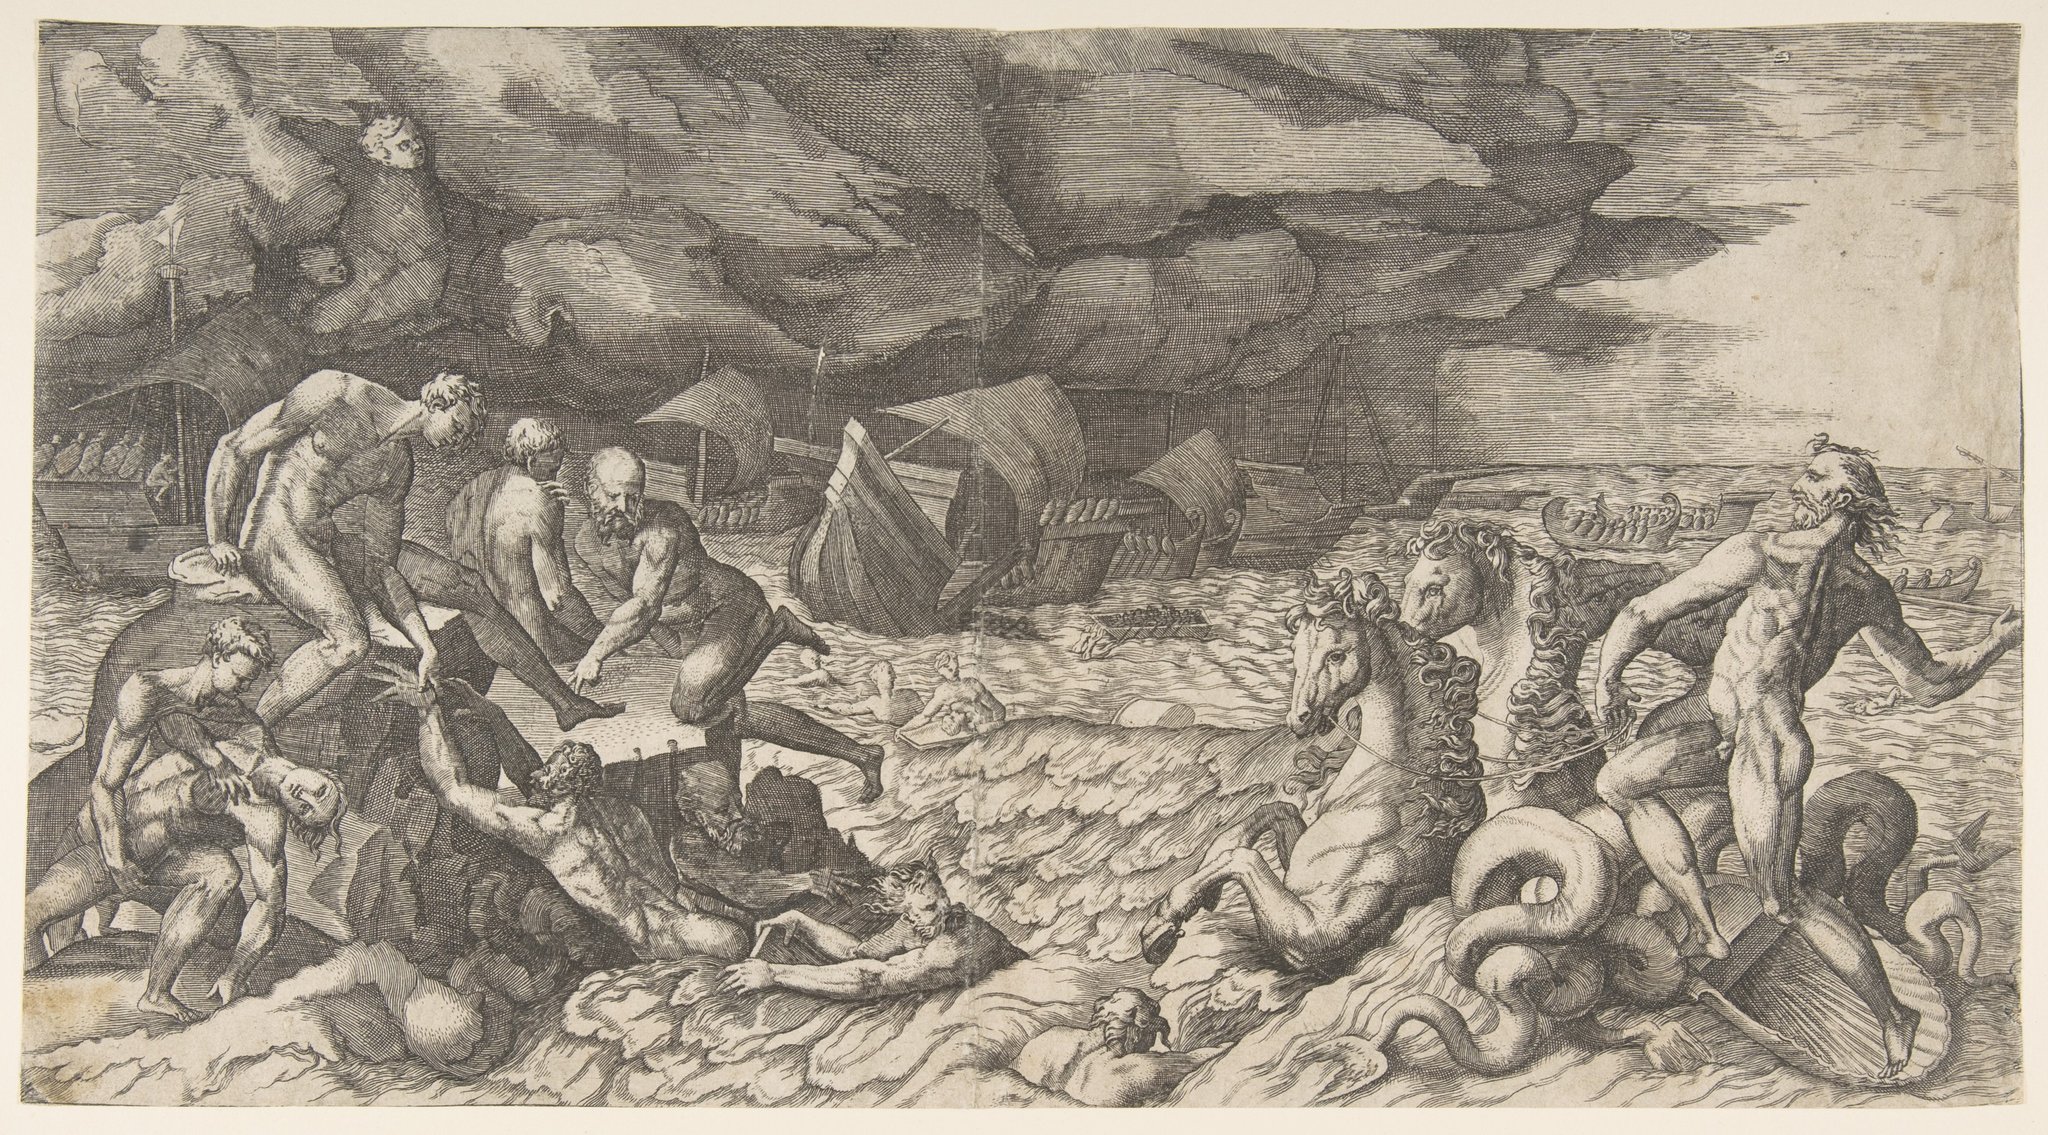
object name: print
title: Neptune calming the Tempest Aeolus raised against the Fleet of Aeneas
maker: giulio bonasone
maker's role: artist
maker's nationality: italian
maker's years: 1510-1576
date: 1531-1576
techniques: engraving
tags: aeneas,neptune